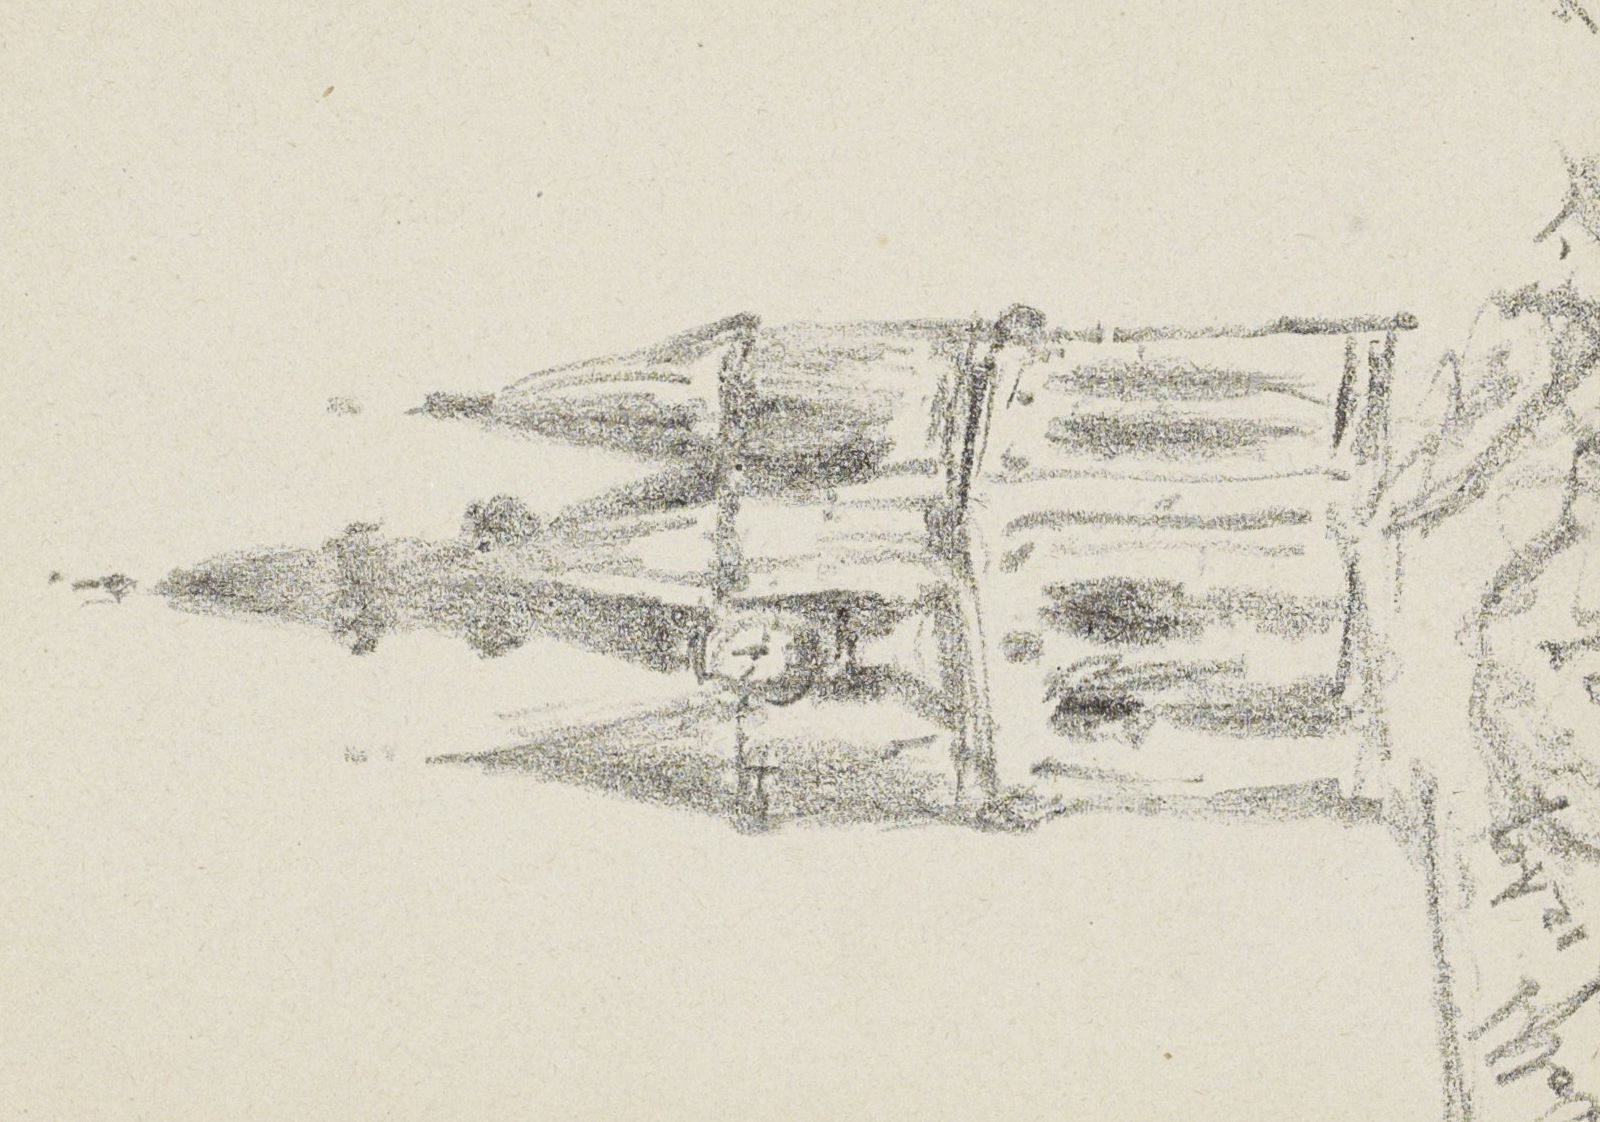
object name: sketchbook leaf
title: Toren van de Oude Kerk te Delft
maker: willem cornelis rip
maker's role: draughtsman, painter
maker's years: 1856-1922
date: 1907-1908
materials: chalk, paper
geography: delft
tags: parts of church exterior and annexes: tower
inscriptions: date and inscription: ‘Delft/ 12 Aug/ 1907’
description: Blad 7 recto uit een schetsboek met 41 bladen.